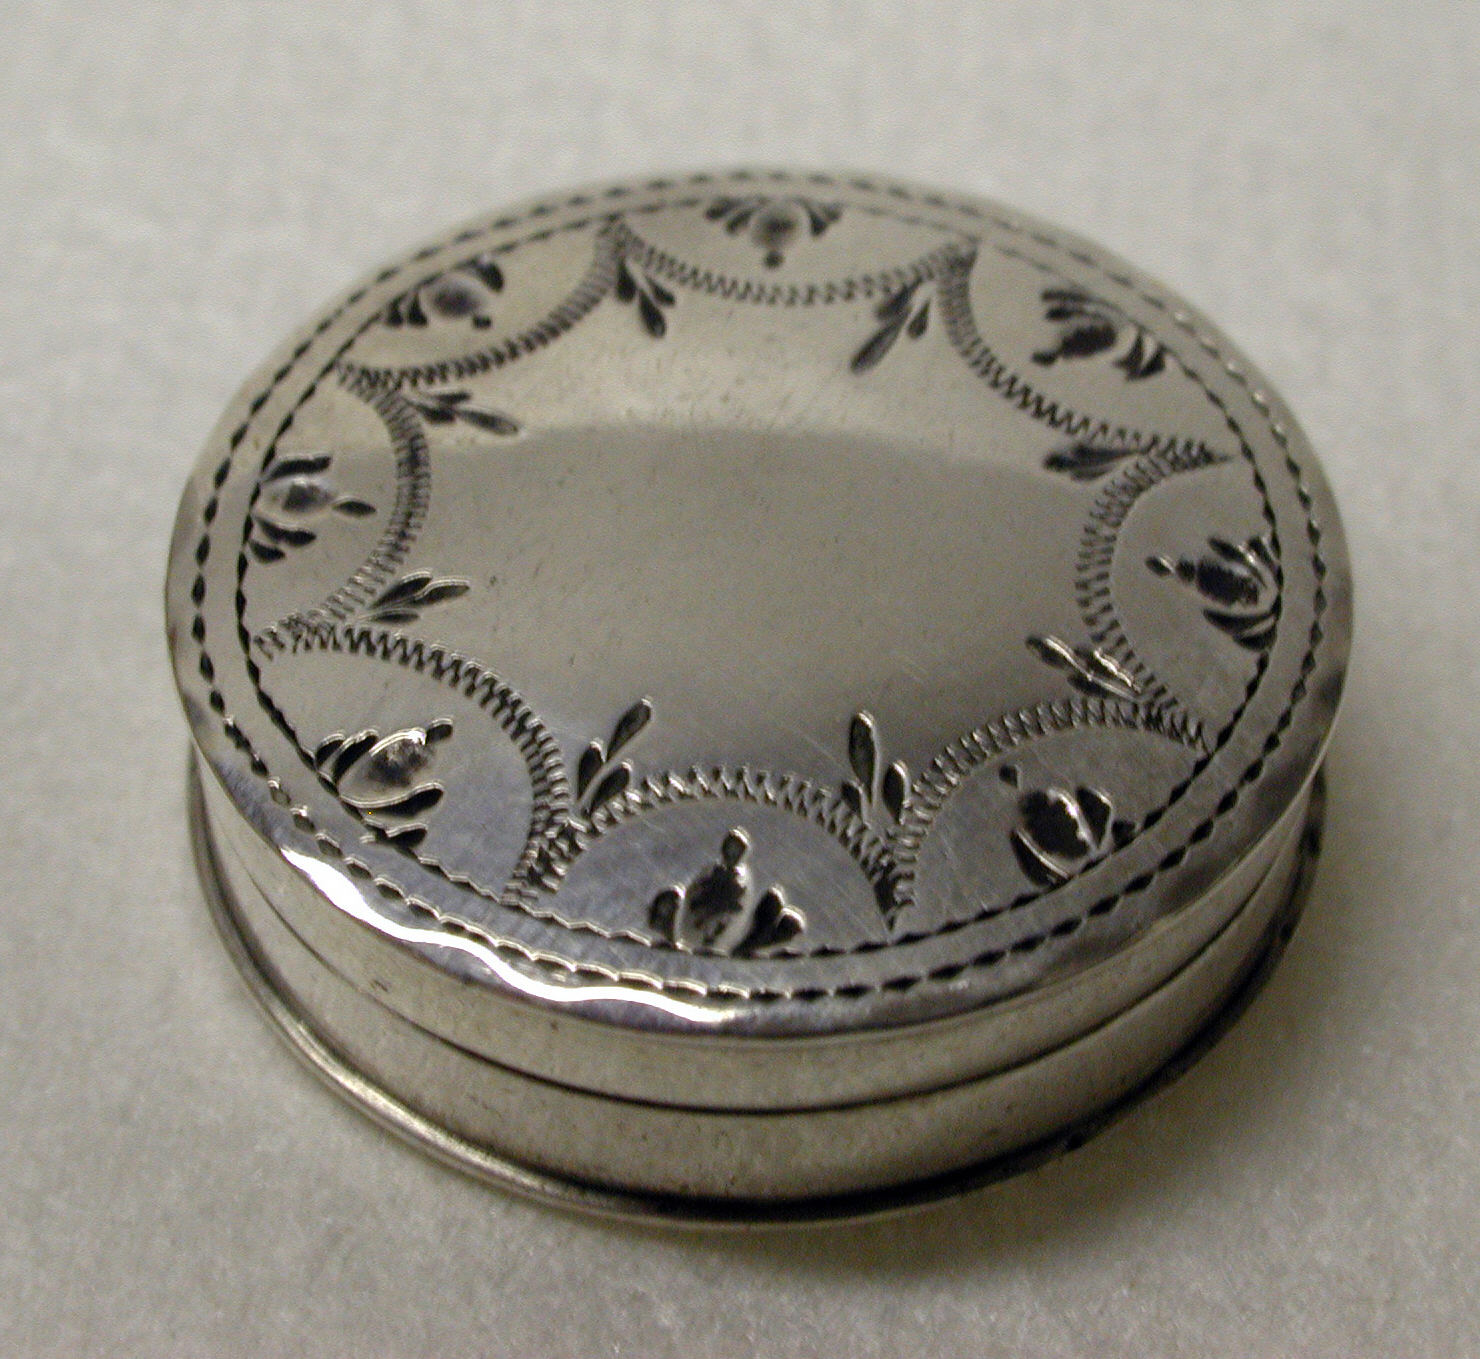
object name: box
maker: samuel pemberton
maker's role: maker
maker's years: 1750-1850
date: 1796-1797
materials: silver